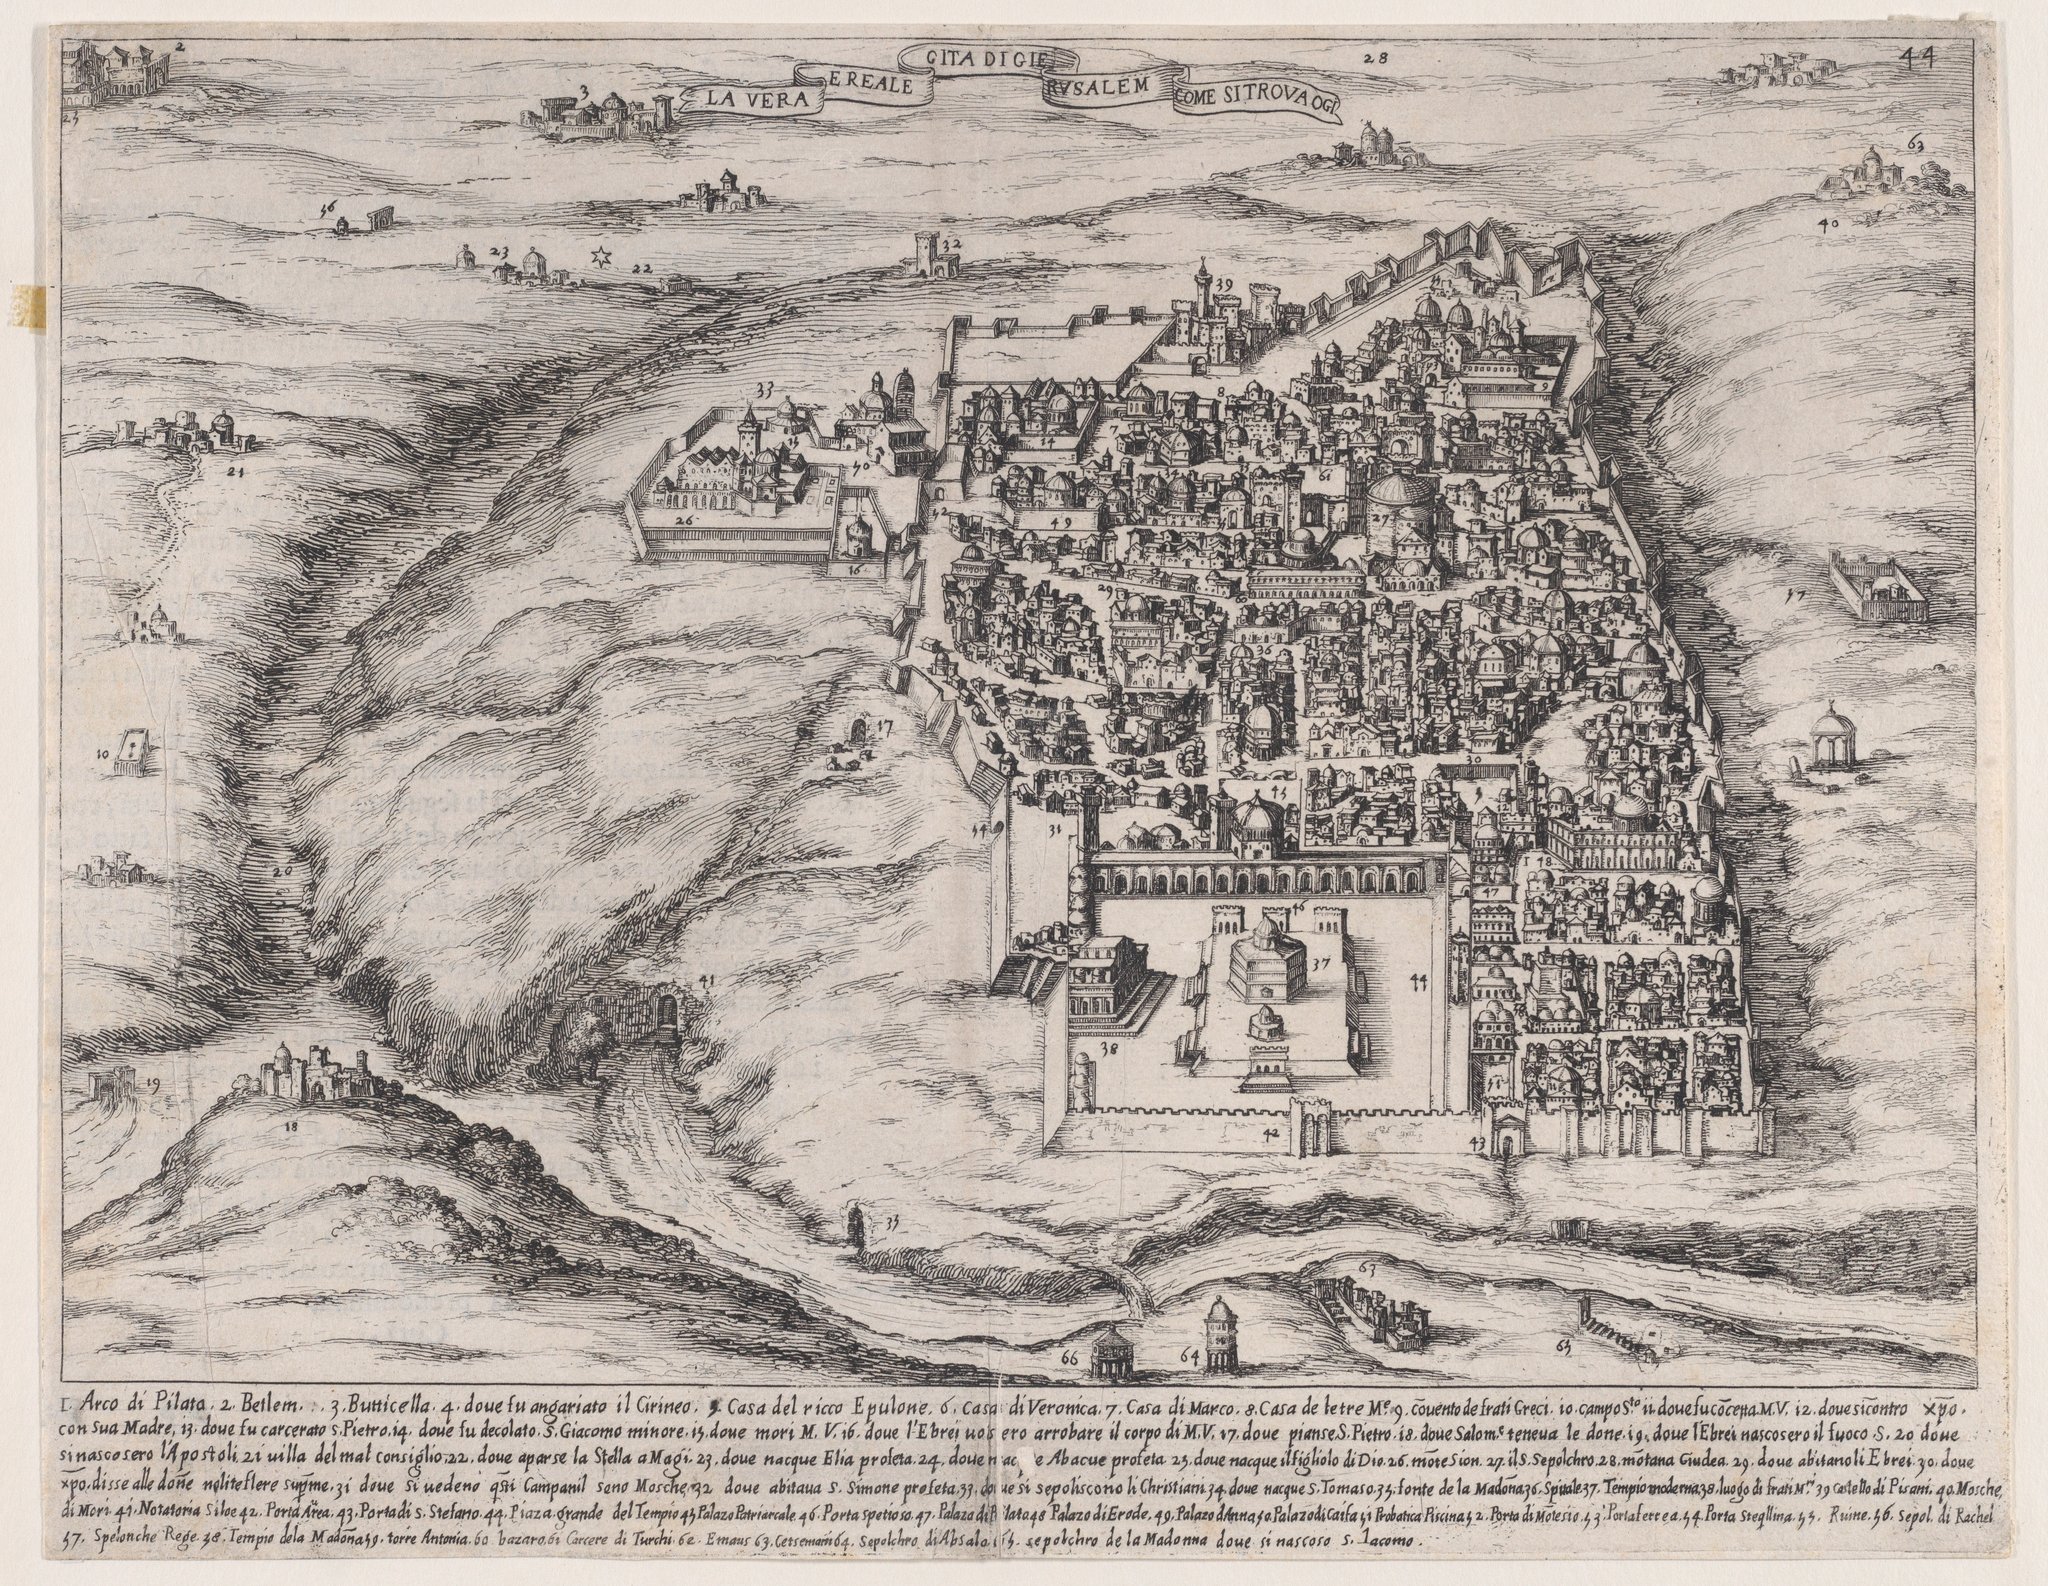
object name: print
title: Plate 36, from "Trattato delle Piante & Immagini de Sacri Edifizi di Terra Santa" (Treatise of the Plans & Images of the Sacred Buildings of the Holy Land)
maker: jacques callot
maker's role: artist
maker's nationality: french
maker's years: 1592-1635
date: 1620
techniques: engraving, etching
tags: buildings